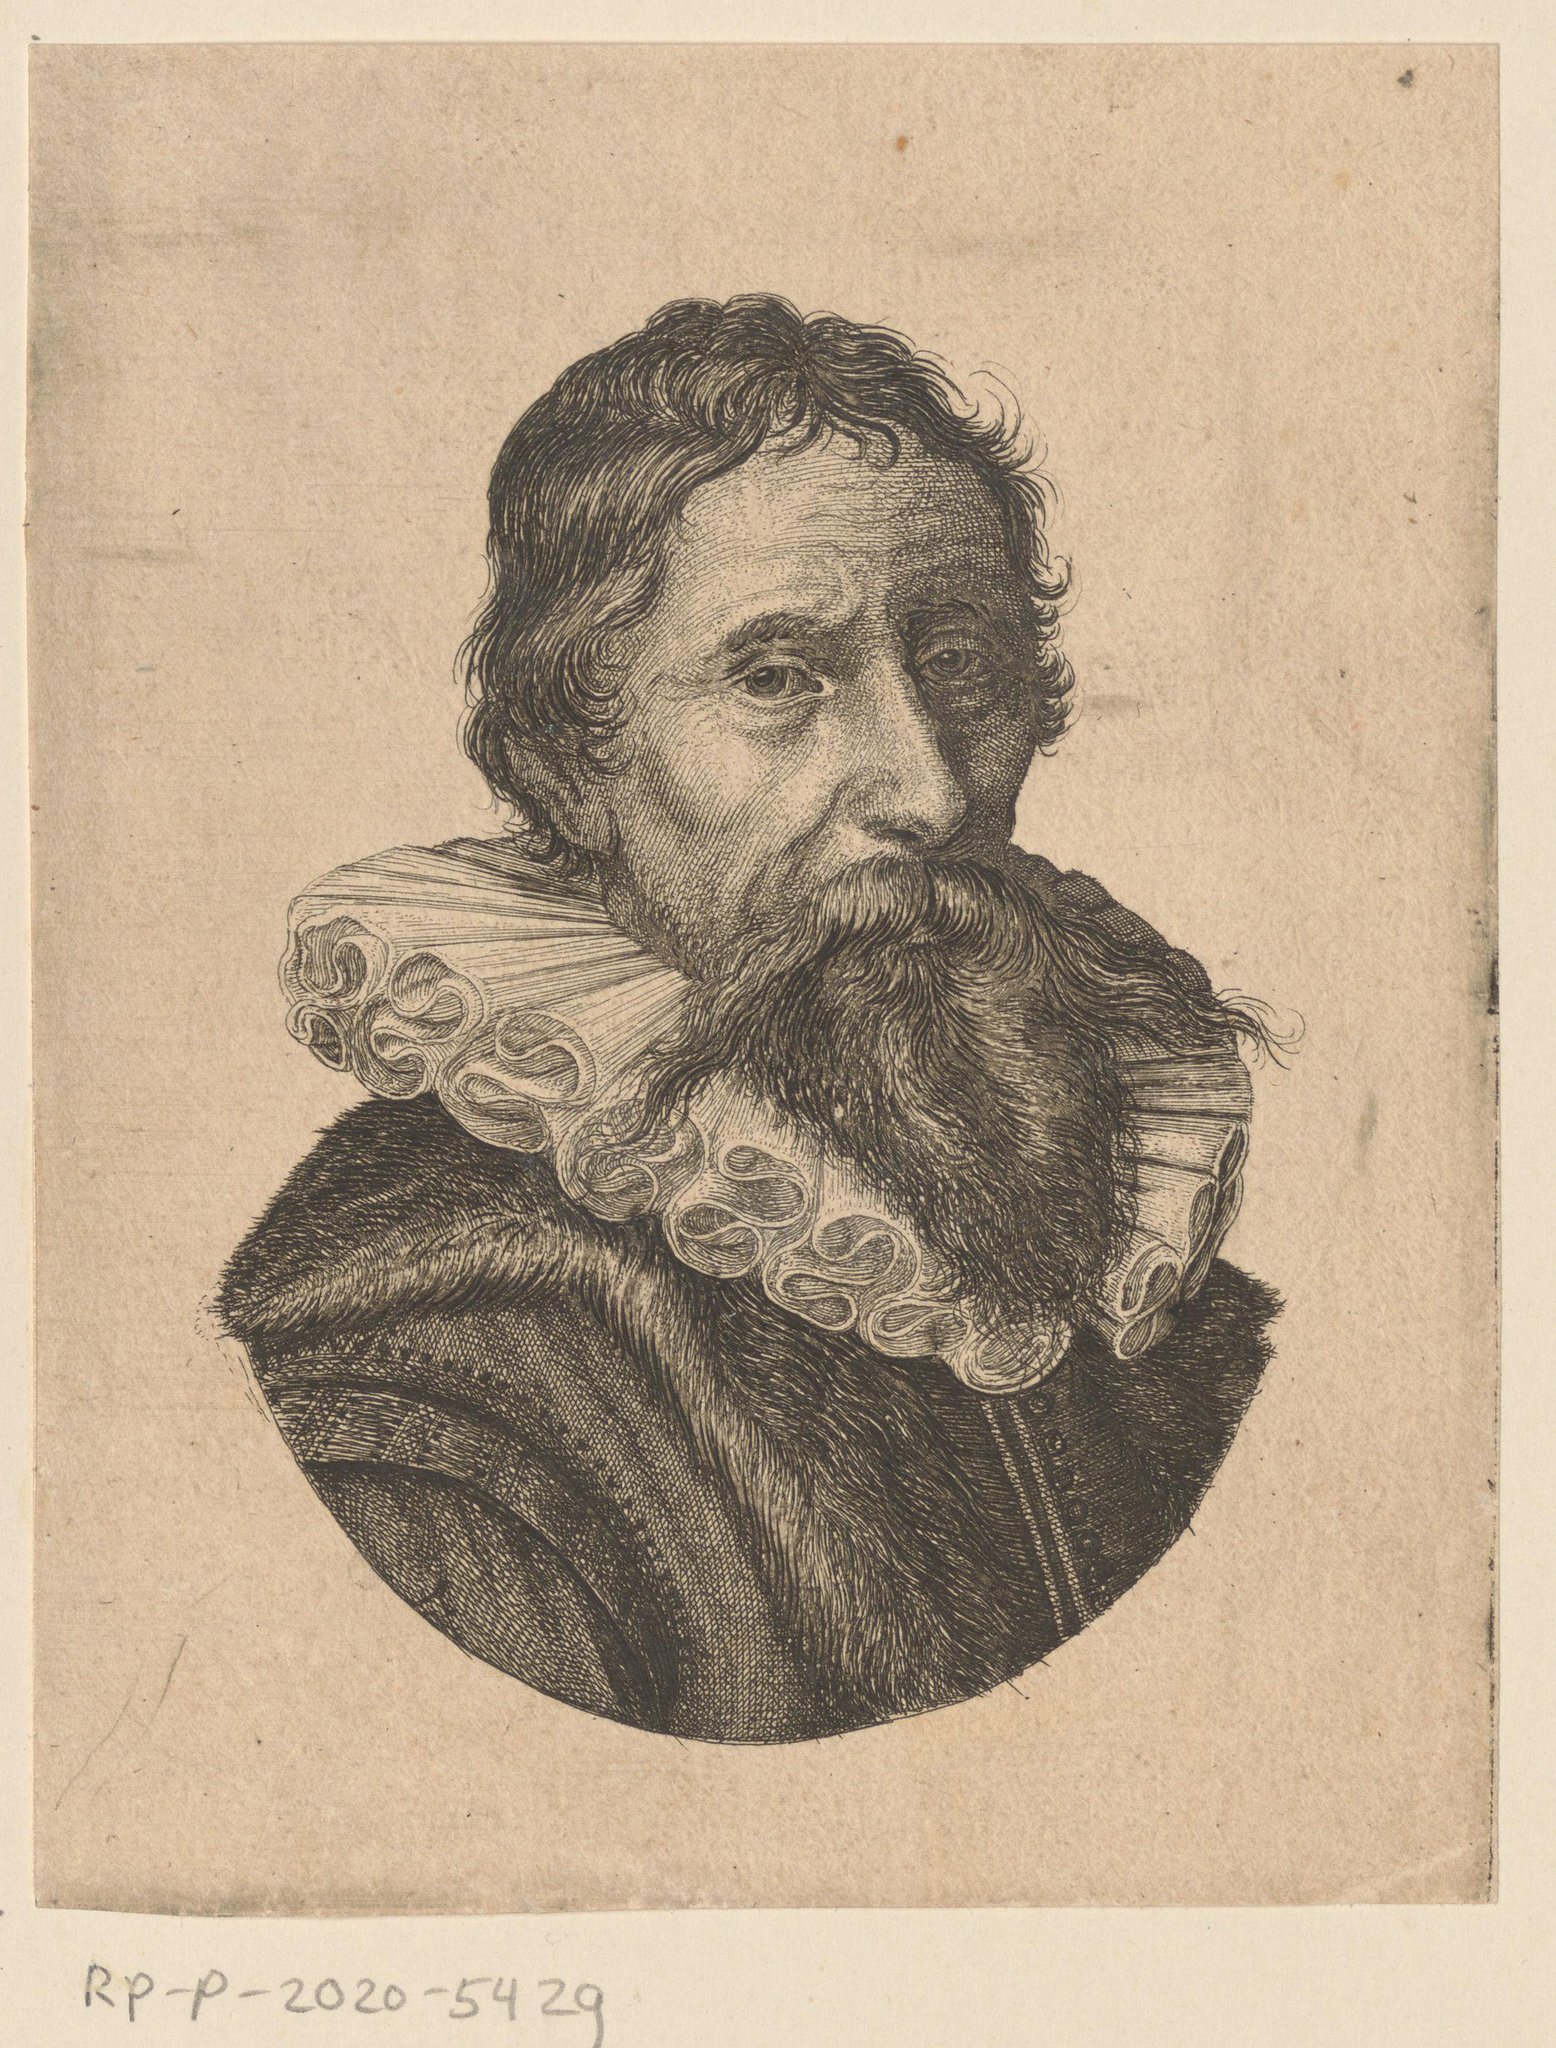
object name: print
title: Portret van Johan Fonteyn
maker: Anonymous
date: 1625-1700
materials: paper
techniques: etching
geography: low countries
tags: amsterdam, historical persons, physician, doctor (+ portrait of scholar, scientist)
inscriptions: inscription: ‘J.n.’